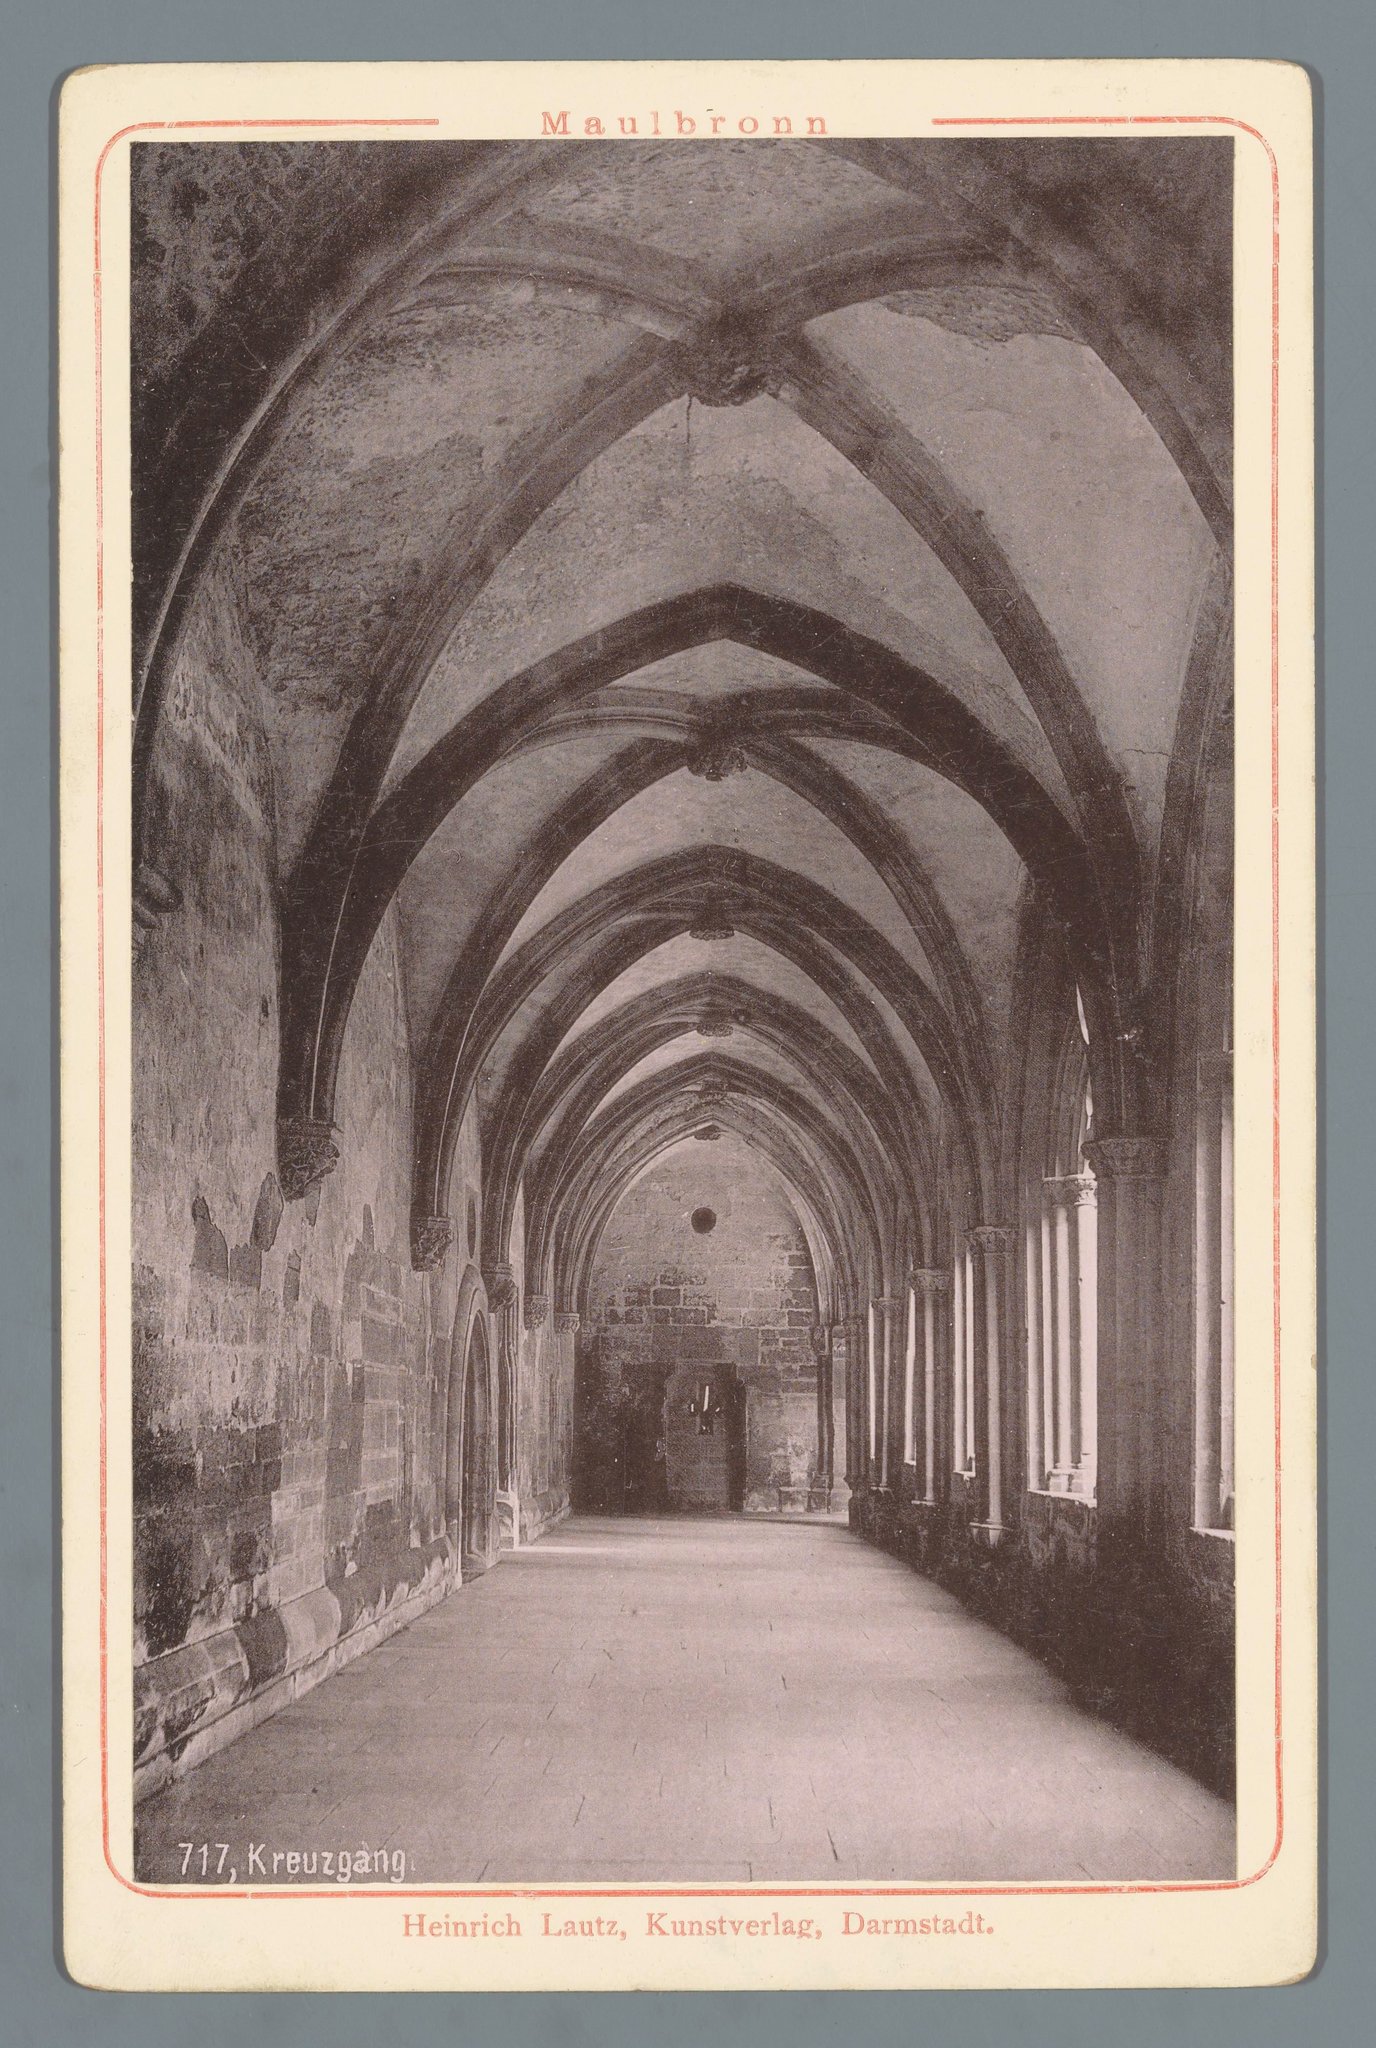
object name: photomechanical print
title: Kloostergang in de Abdij van Maulbronn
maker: Anonymous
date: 1895-1900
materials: cardboard, paper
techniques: photograph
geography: maulbronn abbey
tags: abbey, monastery, convent ~ roman catholic church, staircase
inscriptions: number: ‘717’, inscription: ‘17 Juli 1894.’